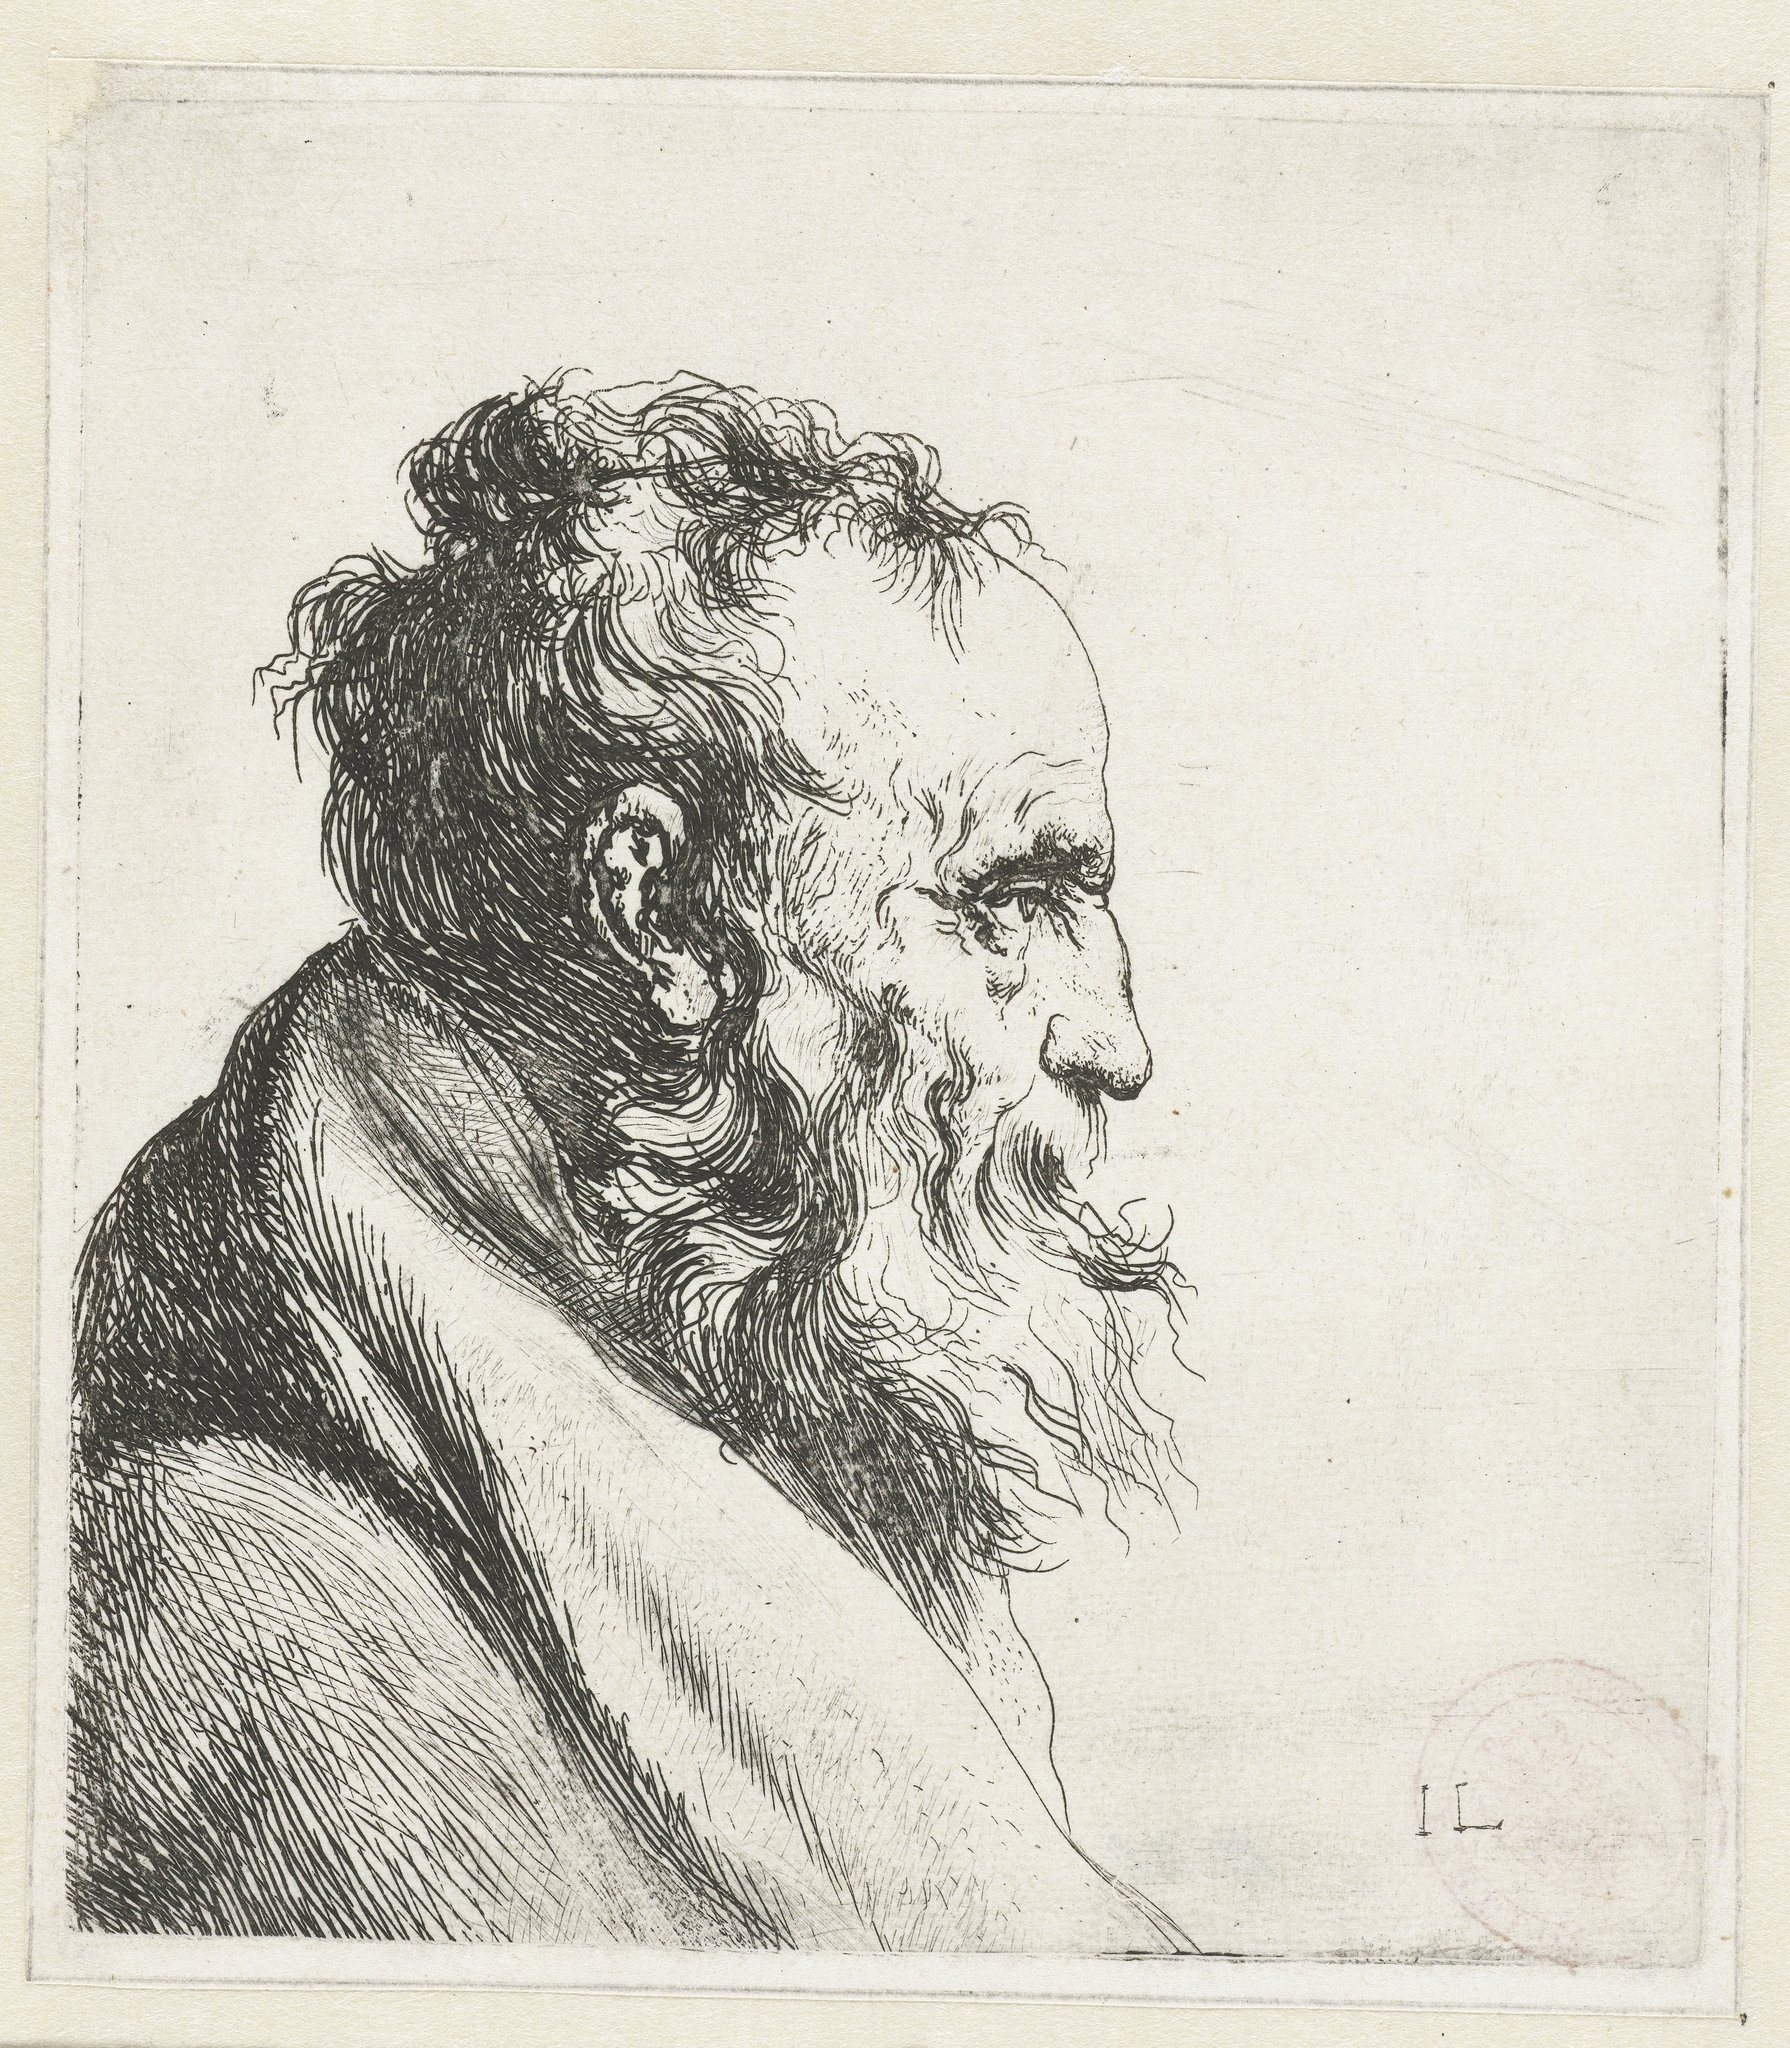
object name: print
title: Diverse tronikens geets van J. L.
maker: jan lievens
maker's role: draughtsman, painter, print maker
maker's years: 1607-1674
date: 1630-1632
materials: paper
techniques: etching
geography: leiden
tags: old man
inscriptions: collector's mark: Lugt 240